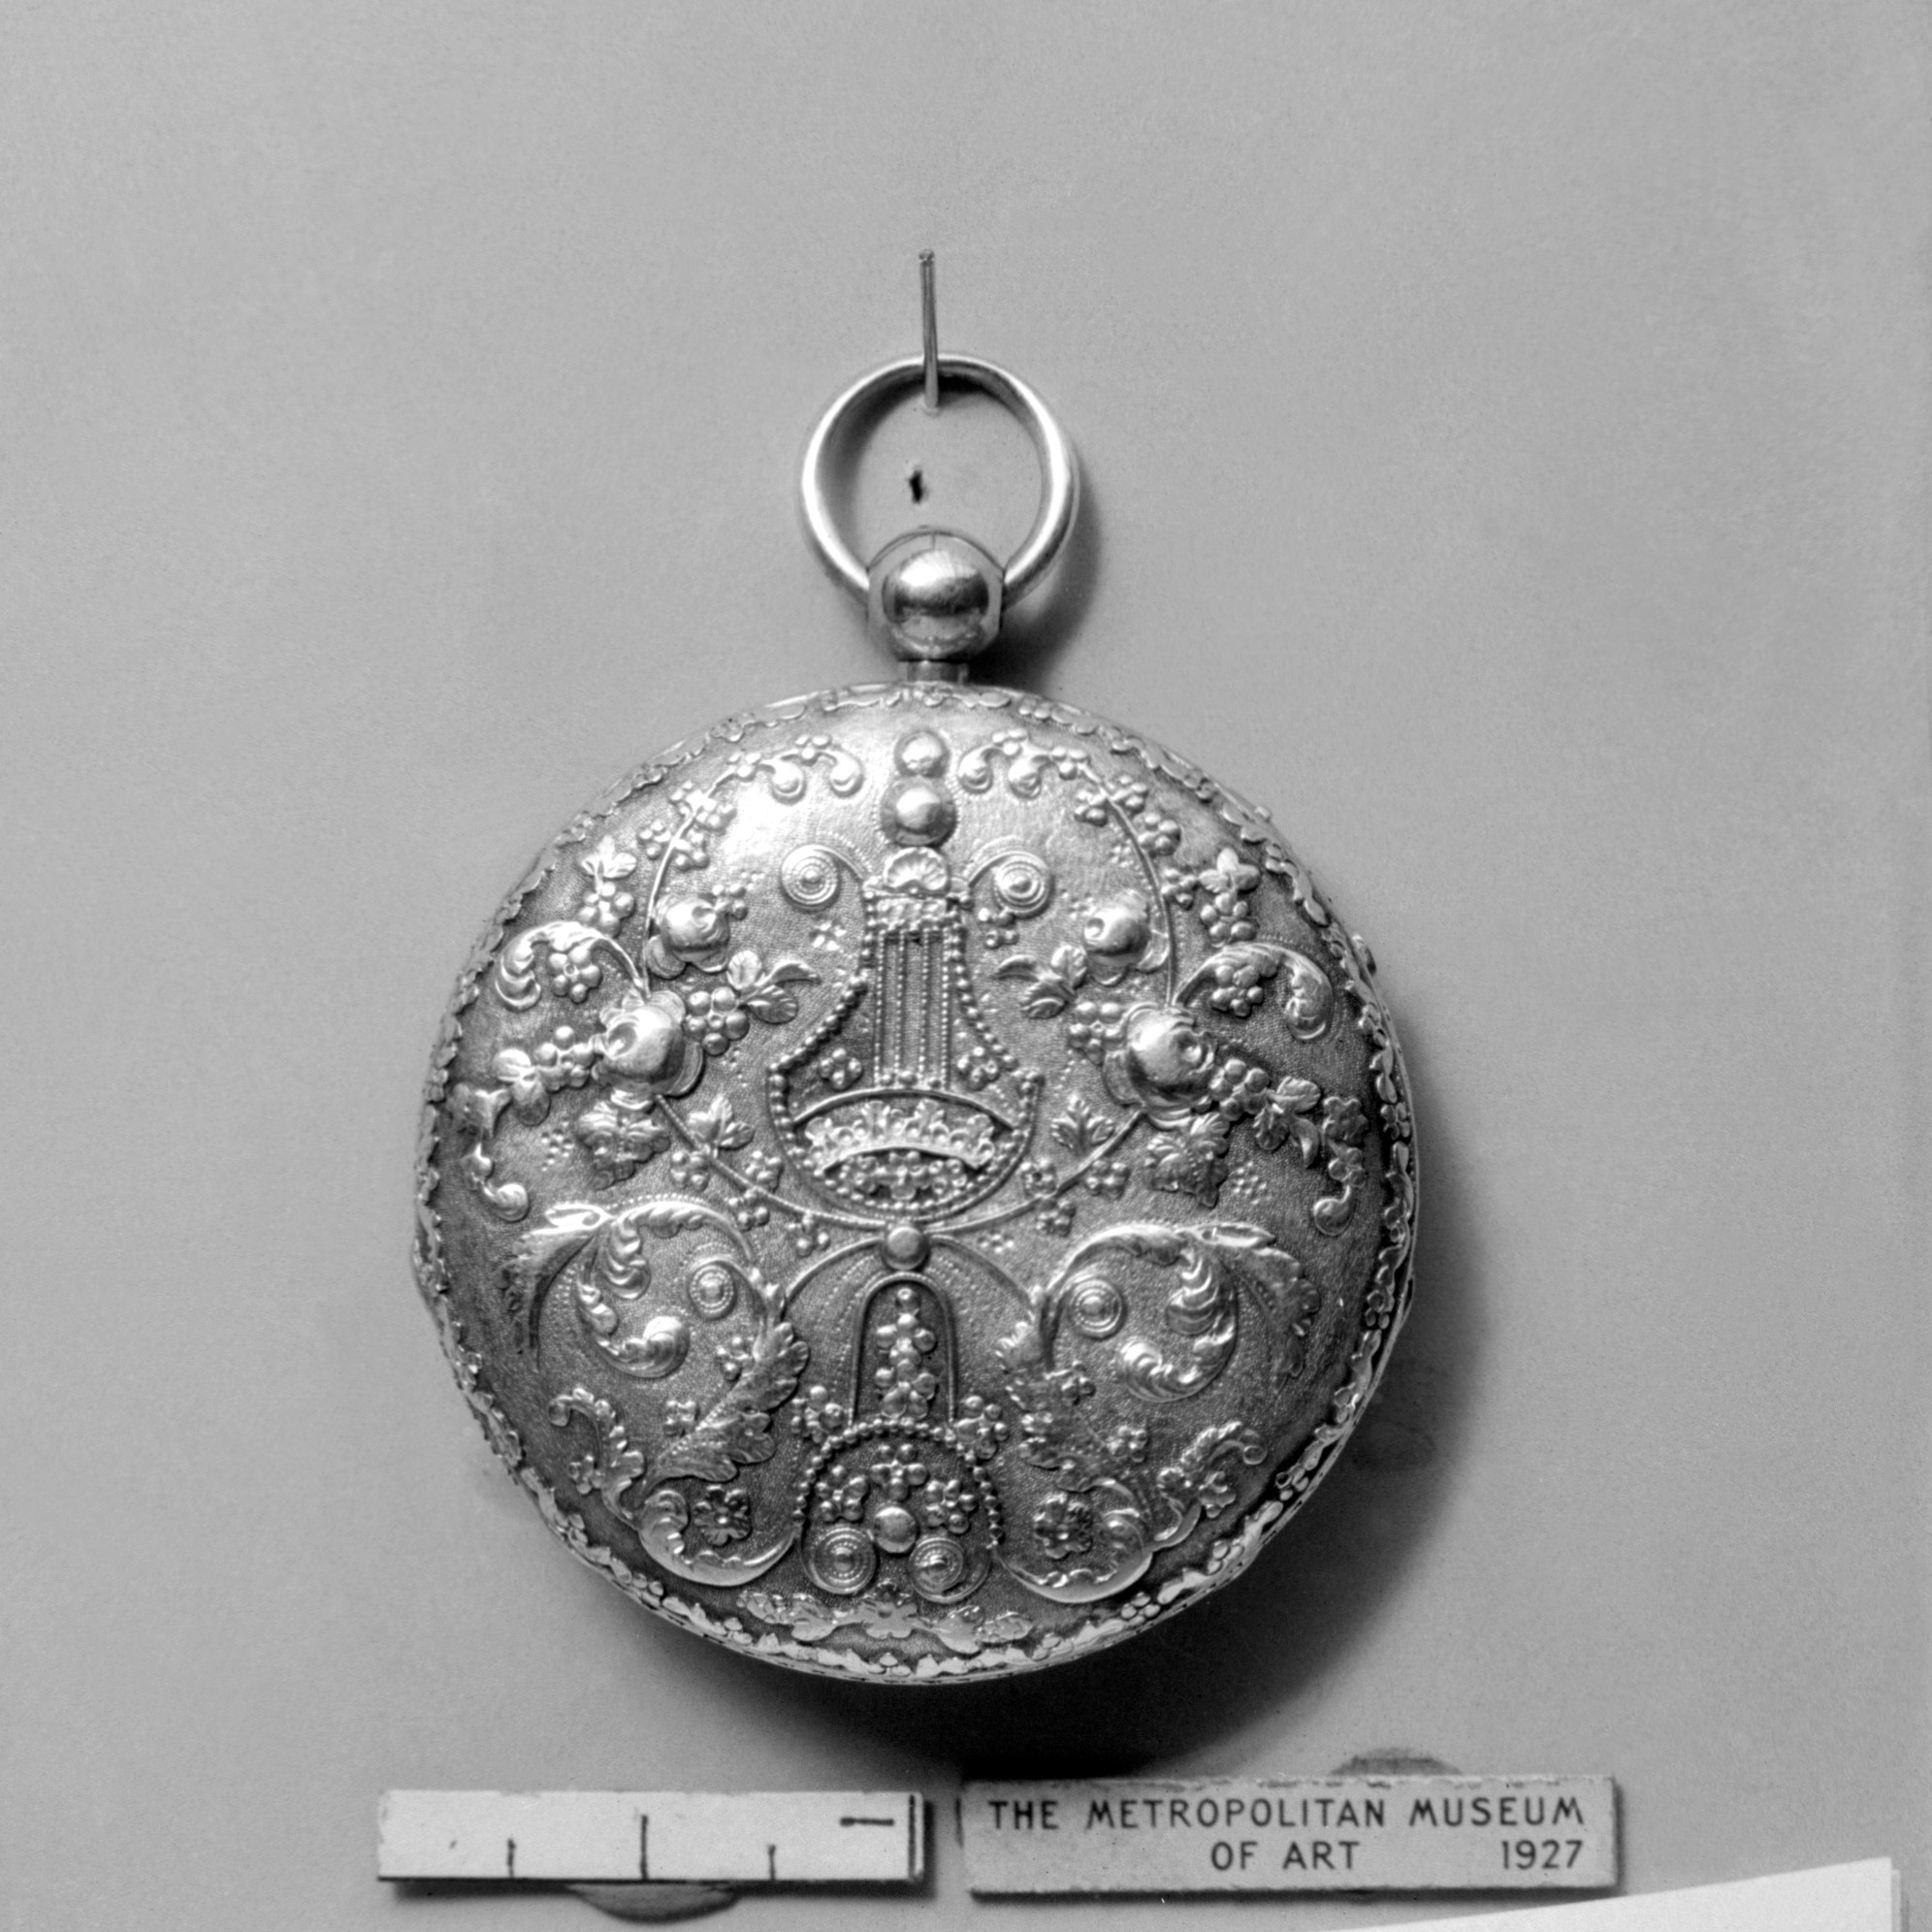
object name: watch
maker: courvoisier & co.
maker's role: maker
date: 1815-1835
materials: gold, silver, steel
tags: flowers,leaves